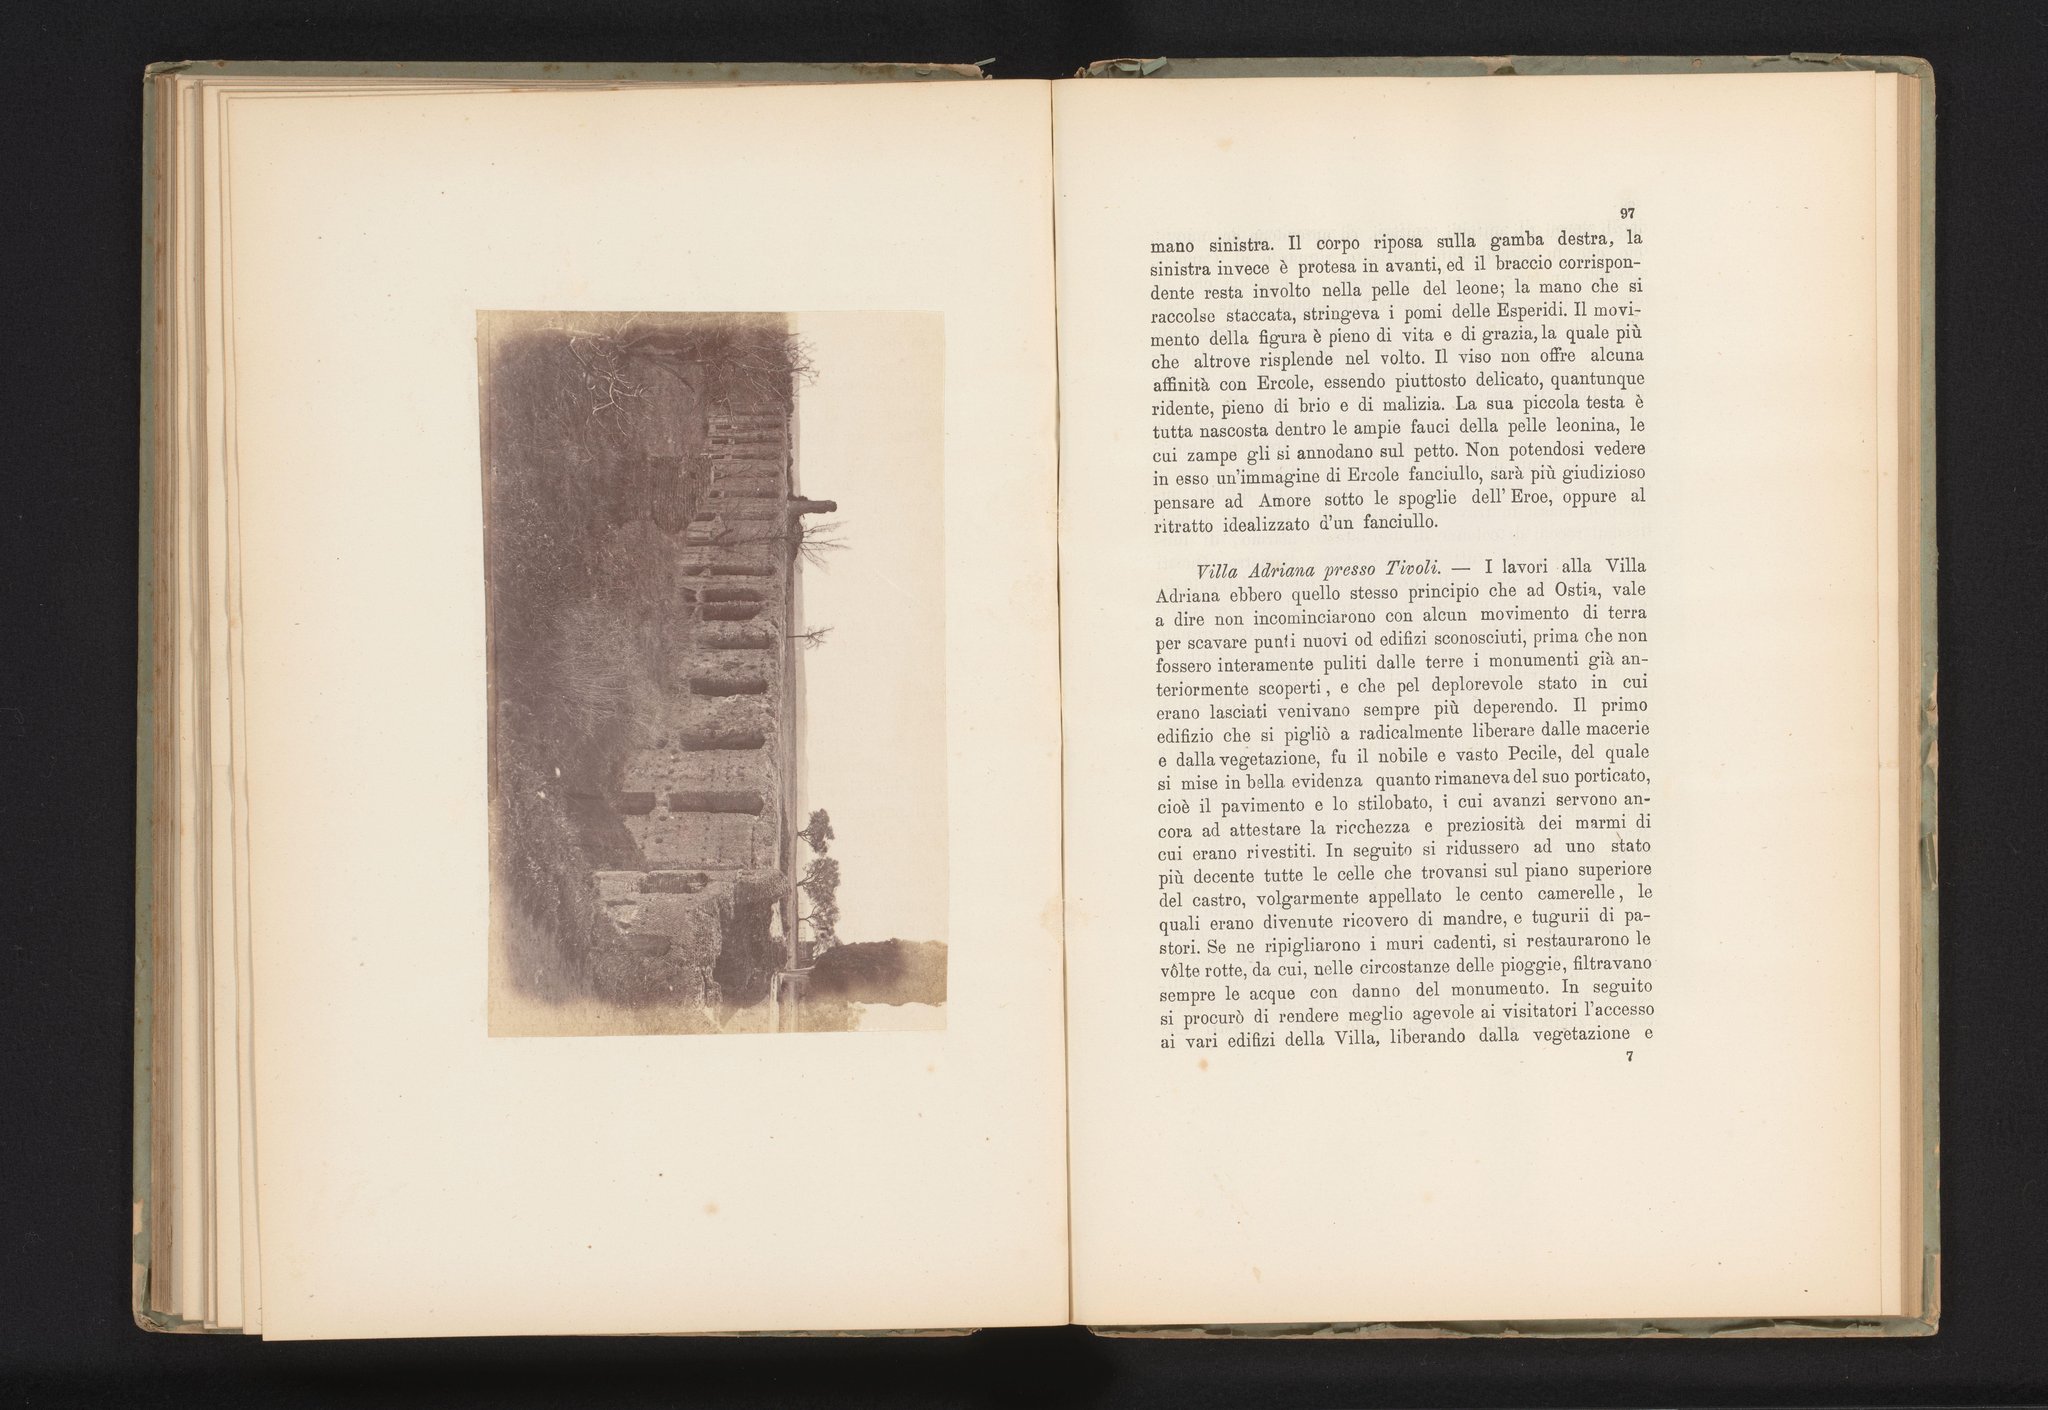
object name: photograph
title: Gezicht op de ruïnes van de Villa Adriana te Tivoli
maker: Anonymous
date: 1863-1873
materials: photographic support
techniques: albumen print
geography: tivoli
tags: ruin of a building ~ architecture, villa